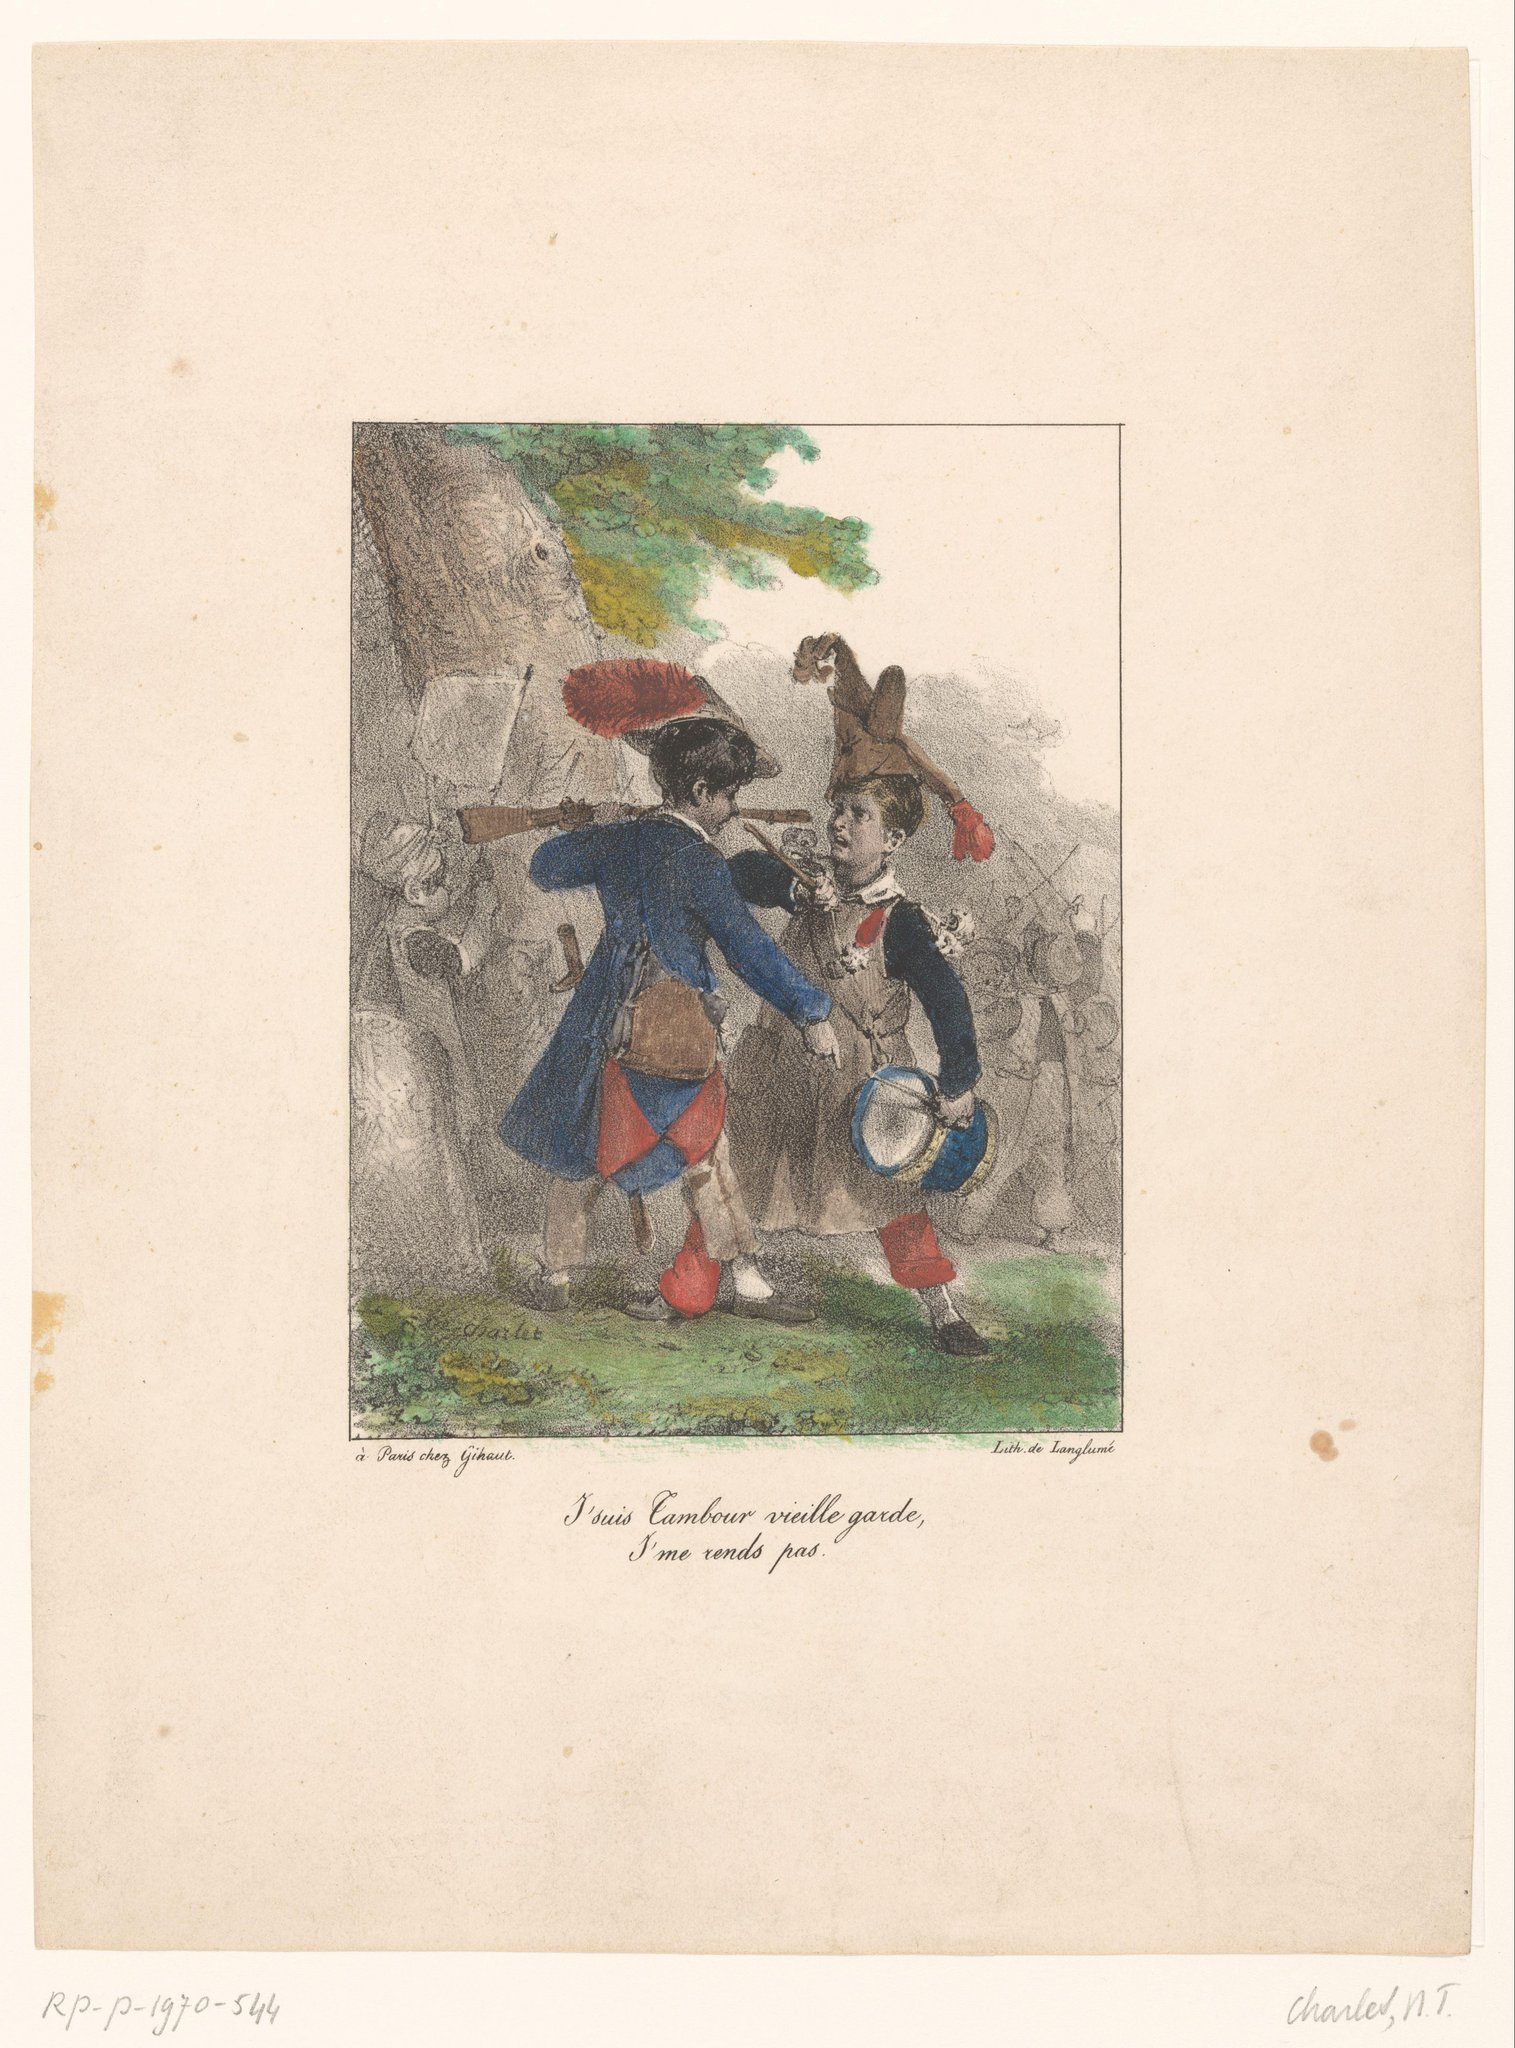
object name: print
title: Twee jongens spelen soldaat en maken ruzie over een trommel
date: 1825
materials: paper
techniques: hand coloring, lithograph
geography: paris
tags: quarrel, argument, drum (musical instrument) - cc - out of doors, games using special objects (marbles, top, hoop, etc.)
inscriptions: collector's mark: Lugt 2228a, collector's mark: ‘L.A. de Vries’